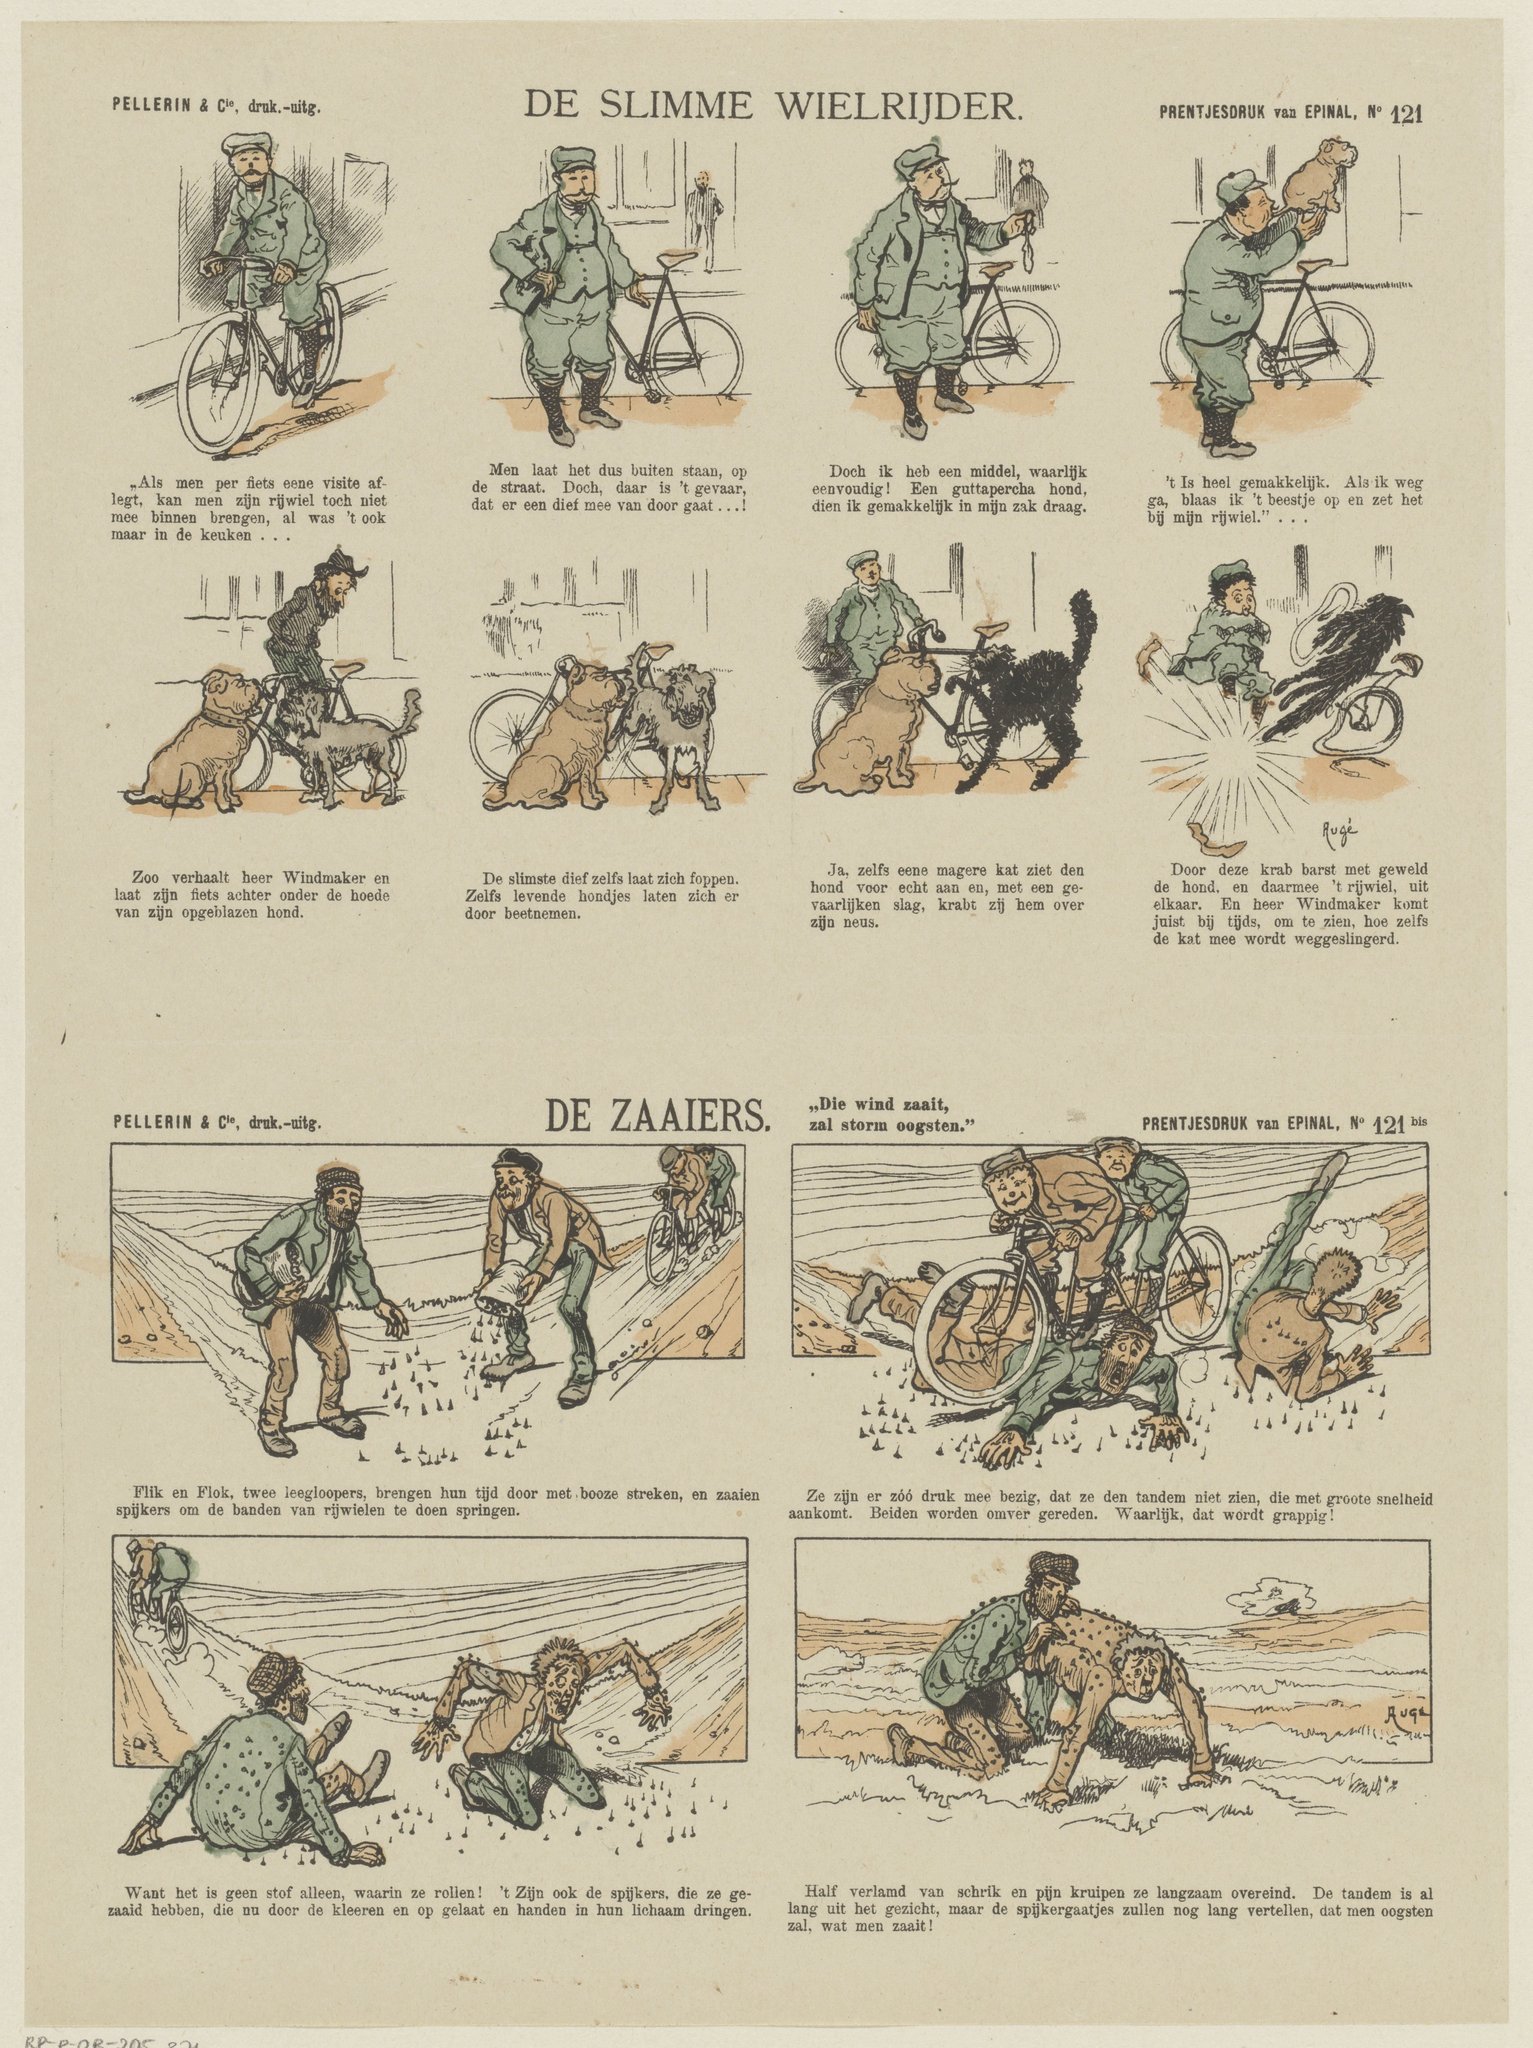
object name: print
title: Prentjesdruk van Epinal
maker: augé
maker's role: print maker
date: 1902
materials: paper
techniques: colour, letterpress printing, lithograph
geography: epinal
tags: tools, aids, implements ~ crafts and industries: nail, dog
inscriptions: collector's mark: Lugt 2760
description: Blad met 12 voorstellingen. Boven 8 voorstellingen over een man die een opblaasbare hond bij zijn fiets zet om fietsendieven af te schrikken. Onder 4 voorstellingen over twee mannen die spijkers over de weg uitstrooien. Onder elke afbeelding een onderschrift. Genummerd rechtsboven: No 121.